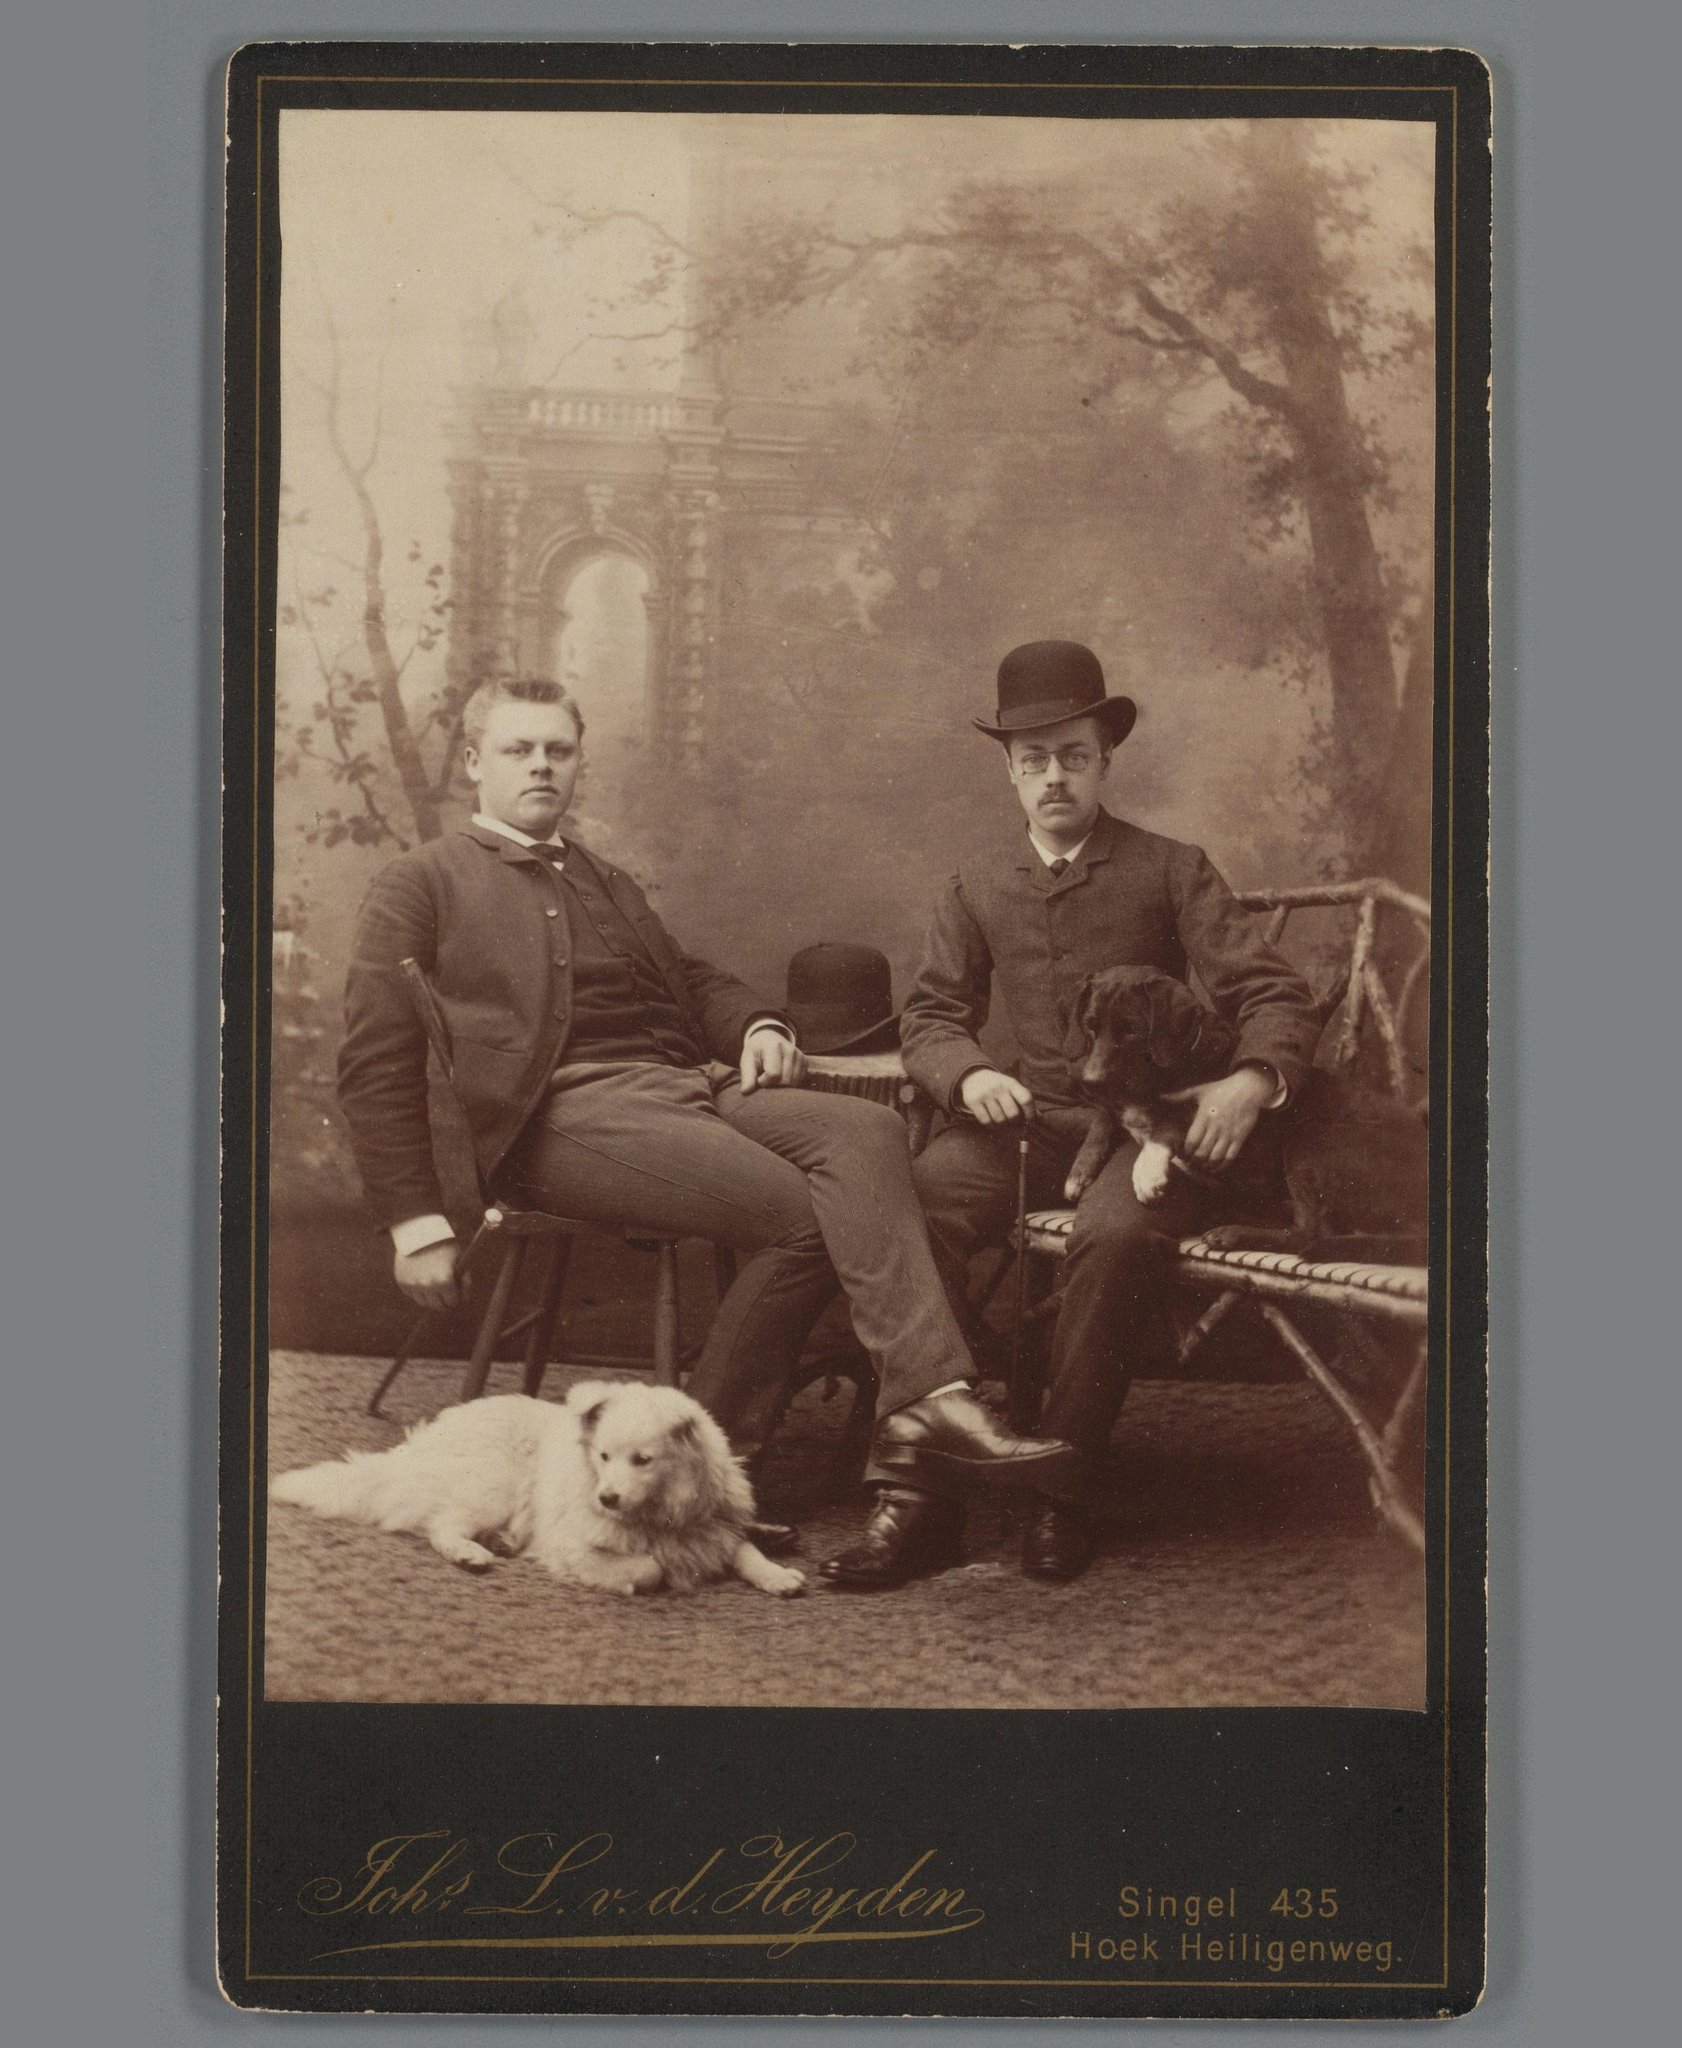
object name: cabinet photograph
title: Portret van twee onbekende mannen met twee honden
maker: johannes leonardus van der heijden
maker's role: fotograaf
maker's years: 1856-1937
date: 1875-1905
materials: cardboard, paper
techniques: albumen print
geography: amsterdam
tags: anonymous historical persons portrayed in a double portrait, dog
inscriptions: address: ‘Singel 435/ Hoek Heiligenweg.’